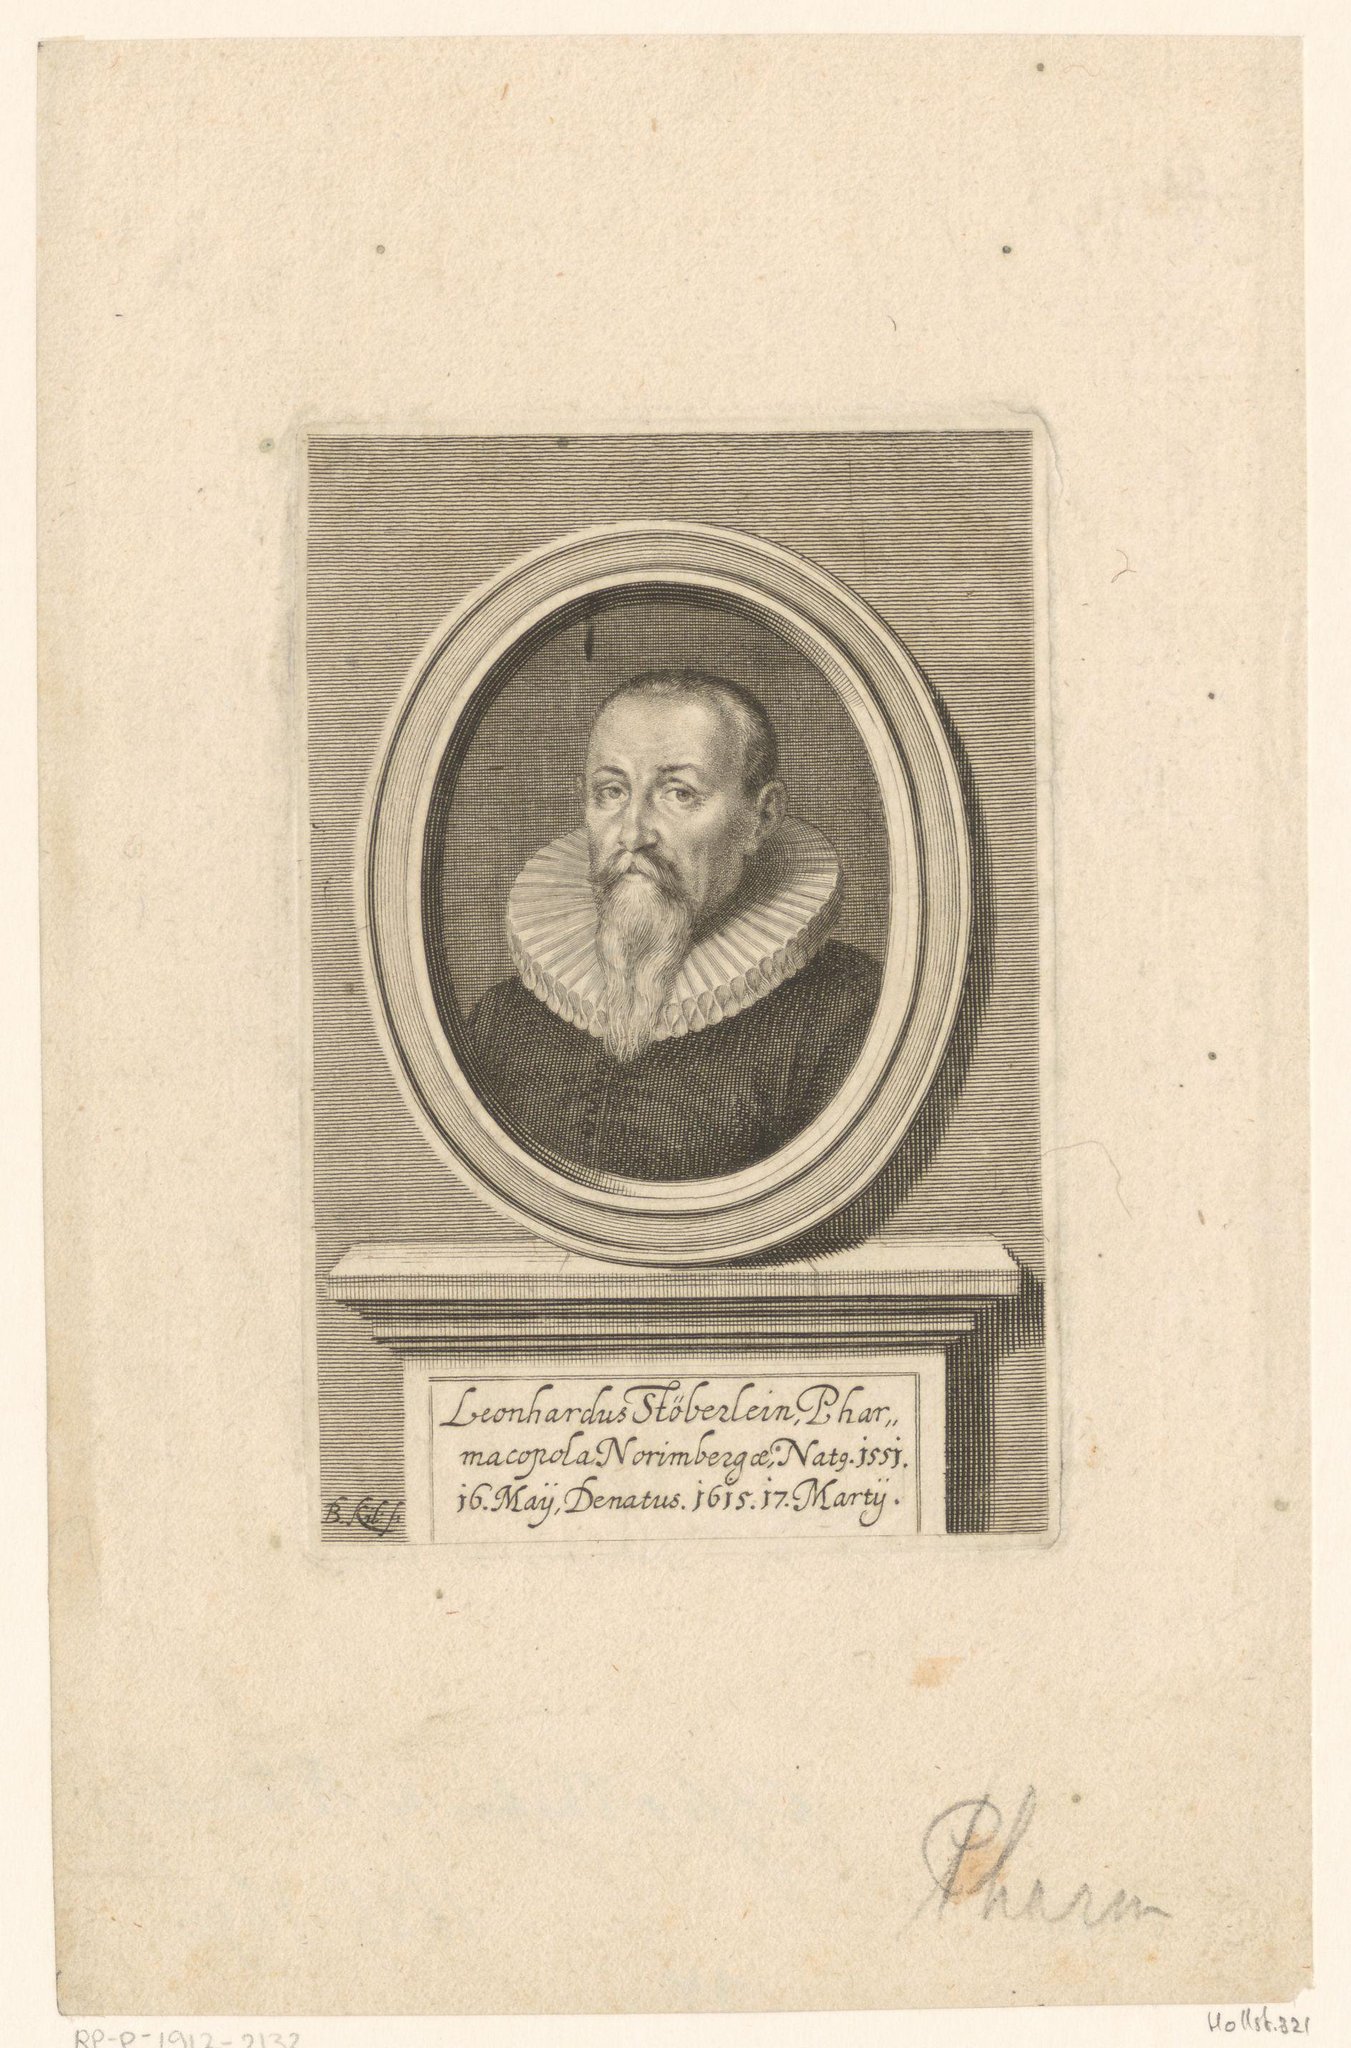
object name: print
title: Portret van Leonhard Stöberlein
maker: bartholomäus kilian (ii)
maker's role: artist, draughtsman, print maker, publisher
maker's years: 1630-1696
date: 1640-1696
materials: paper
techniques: engraving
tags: pharmacist, druggist, apothecary; pharmacy, drugstore, dispensing chemist (+ portrait of scholar, scientist), historical persons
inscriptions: collector's mark: Lugt 2228